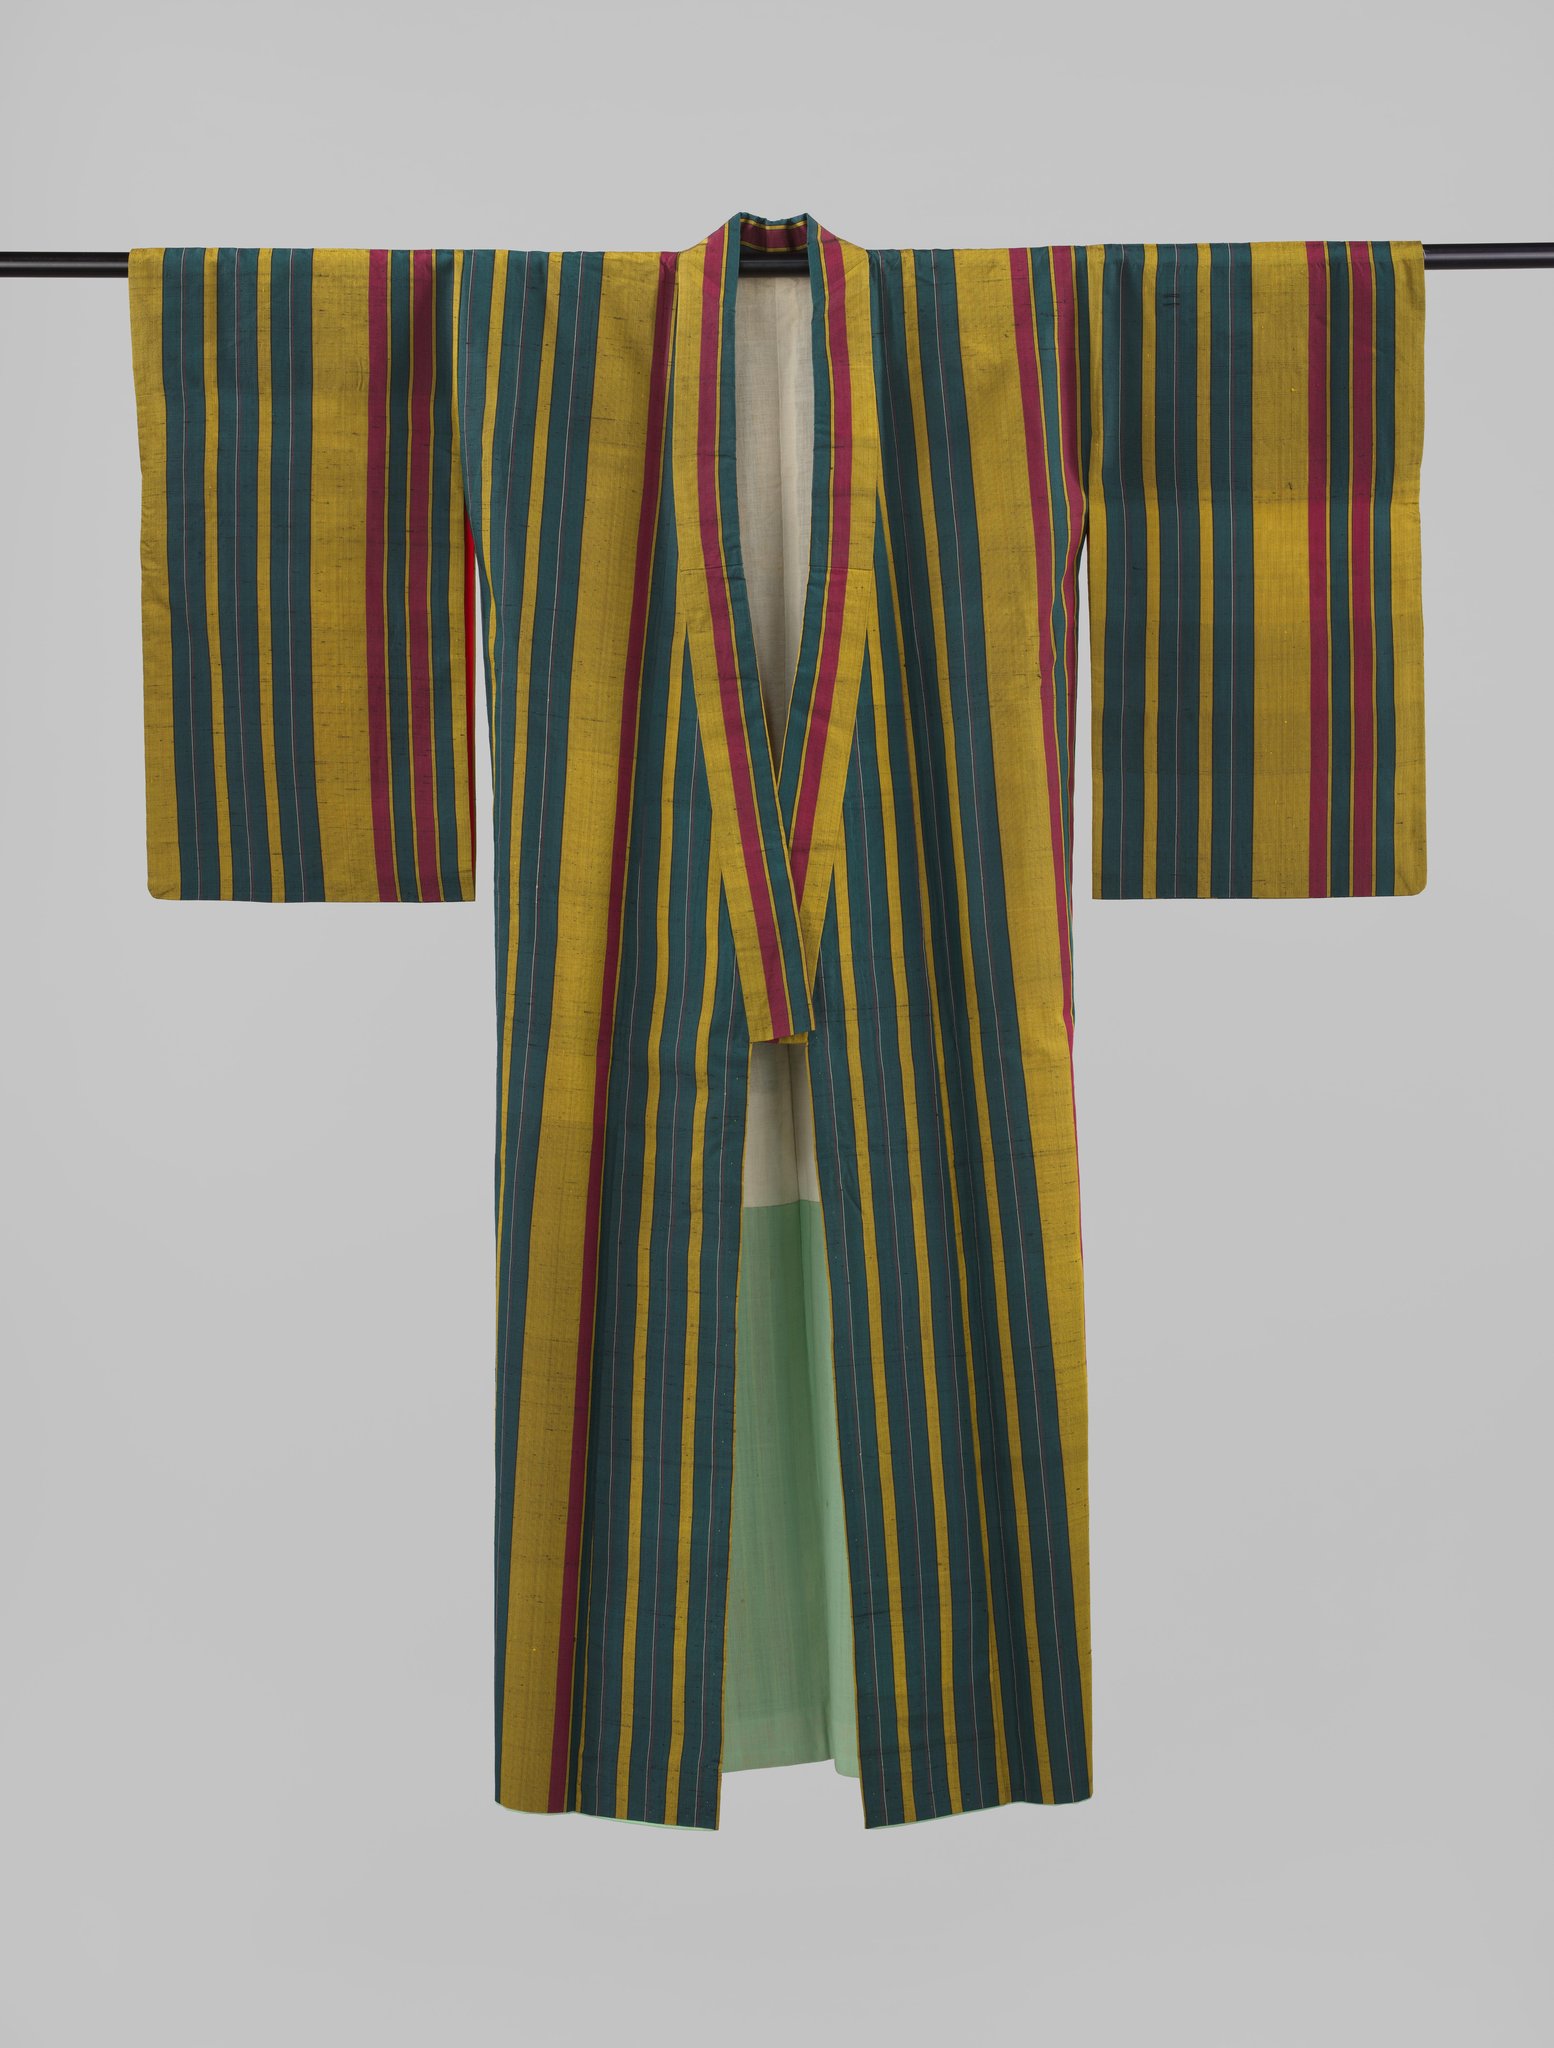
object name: kimono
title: Vrouwen kimono met strepen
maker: Anonymous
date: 1920-1940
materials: silk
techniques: weave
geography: japan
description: Informele vrouwen kimono met verticale paarse, blauwe en goudgele strepen. Voering van rood, wit en goudgeel gestreepte zijde.